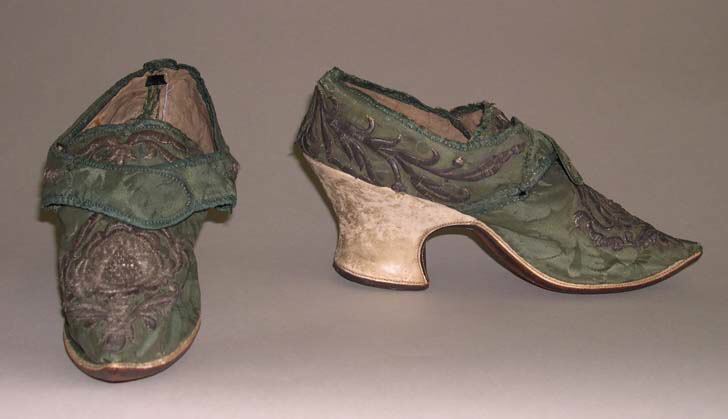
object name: shoe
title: Shoes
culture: british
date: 1720-1739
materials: silk, silver